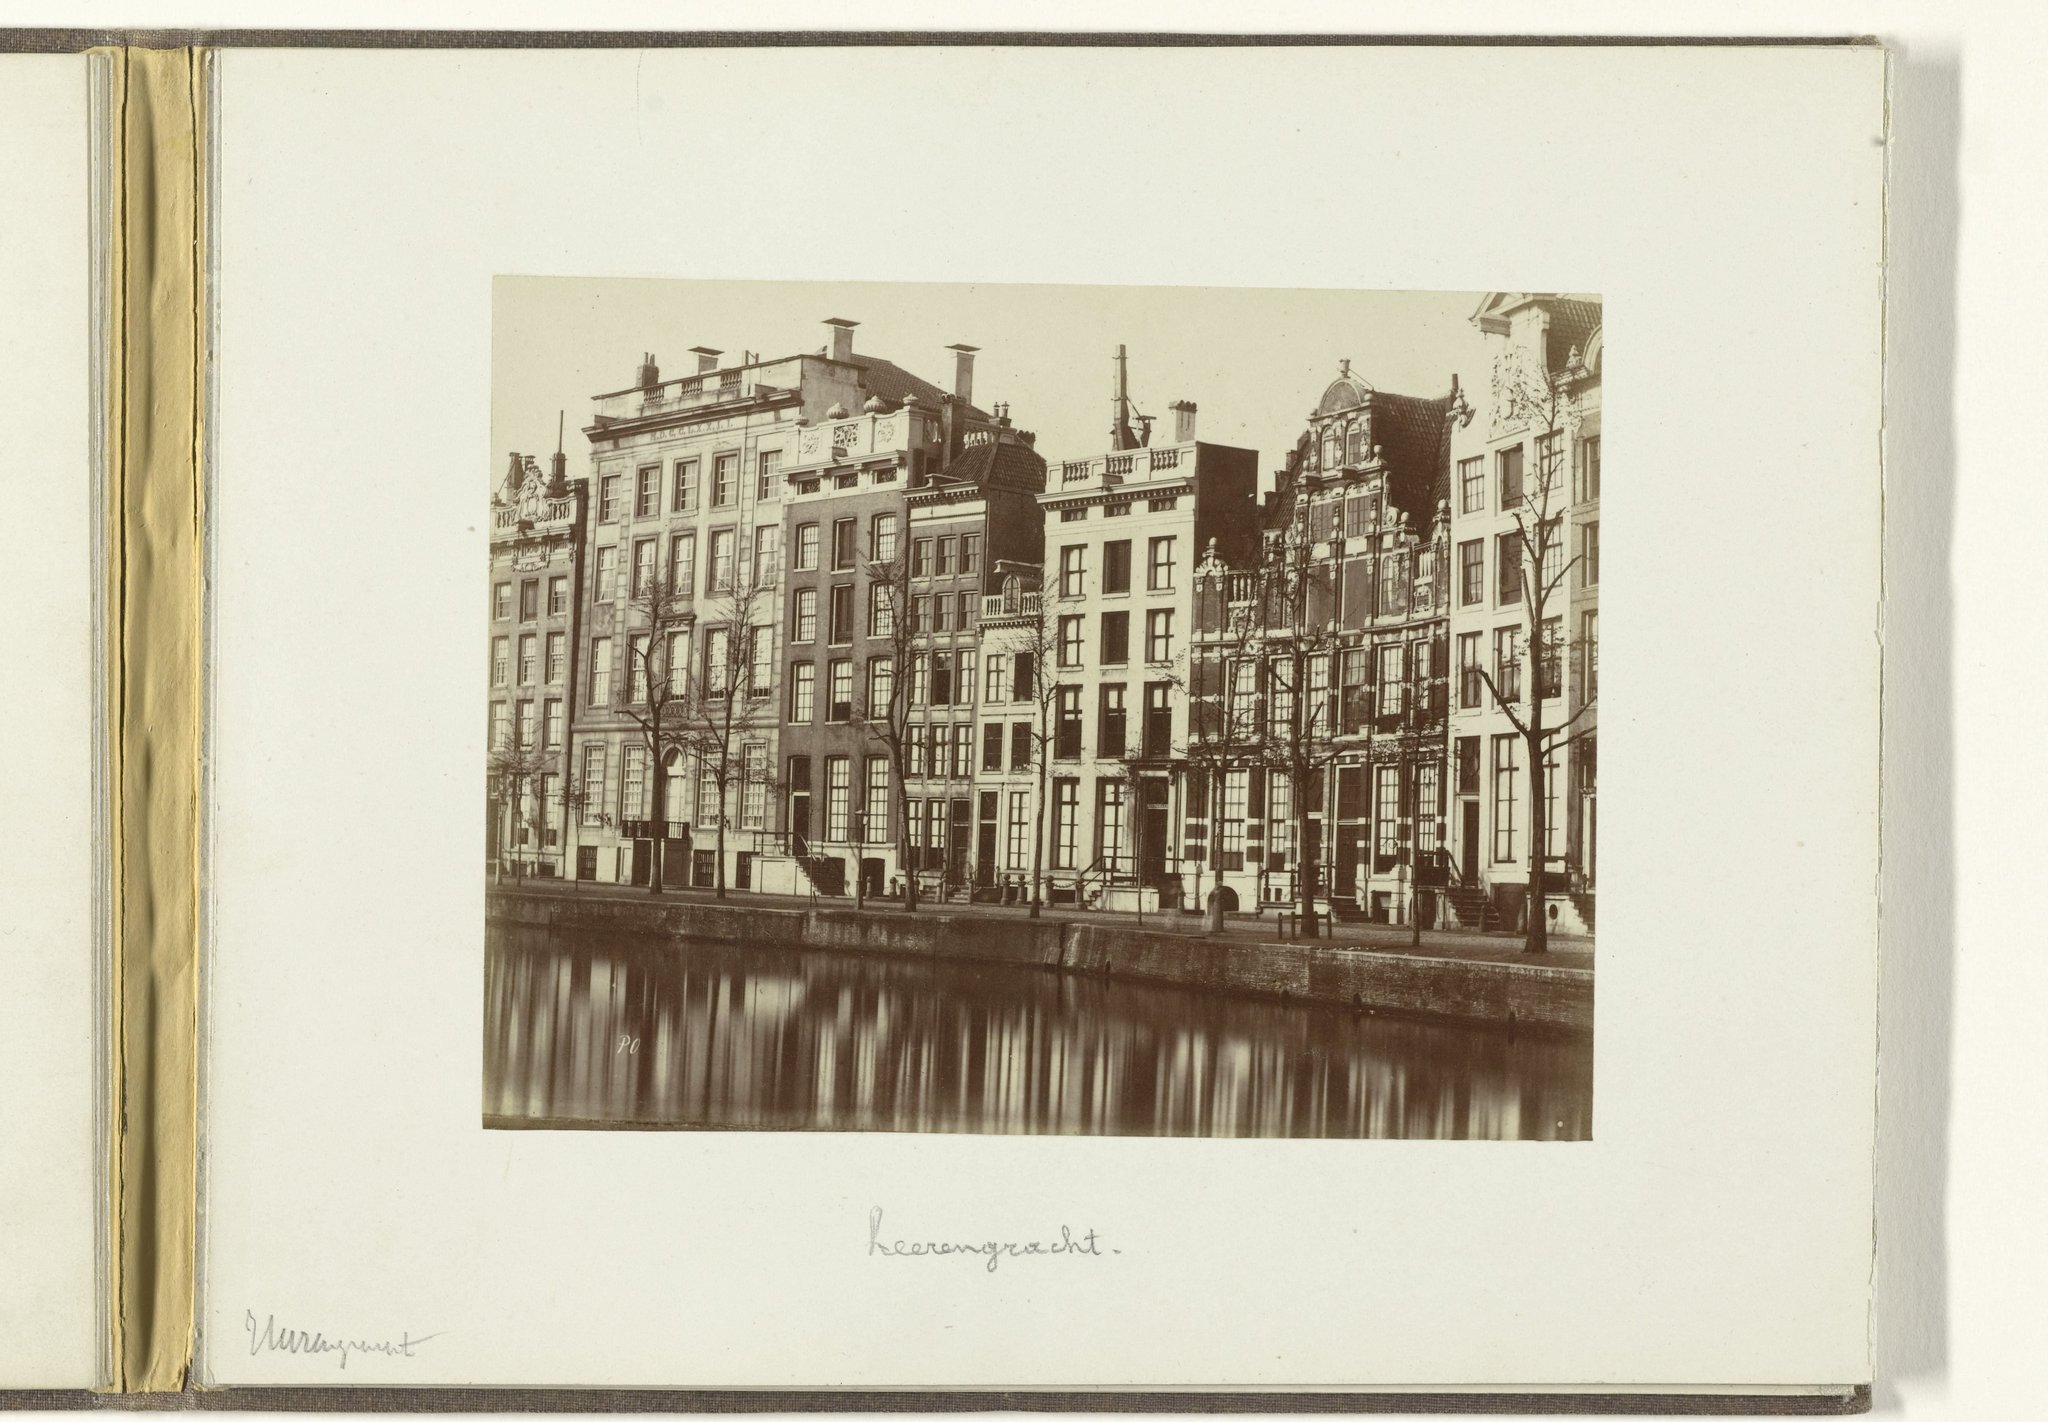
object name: photograph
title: Heerengracht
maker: pieter oosterhuis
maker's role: draughtsman, print maker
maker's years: 1816-1885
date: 1855-1860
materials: paper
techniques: albumen print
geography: amsterdam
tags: urban housing, canals, waters (in city)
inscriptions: inscription: ‘heerengracht’